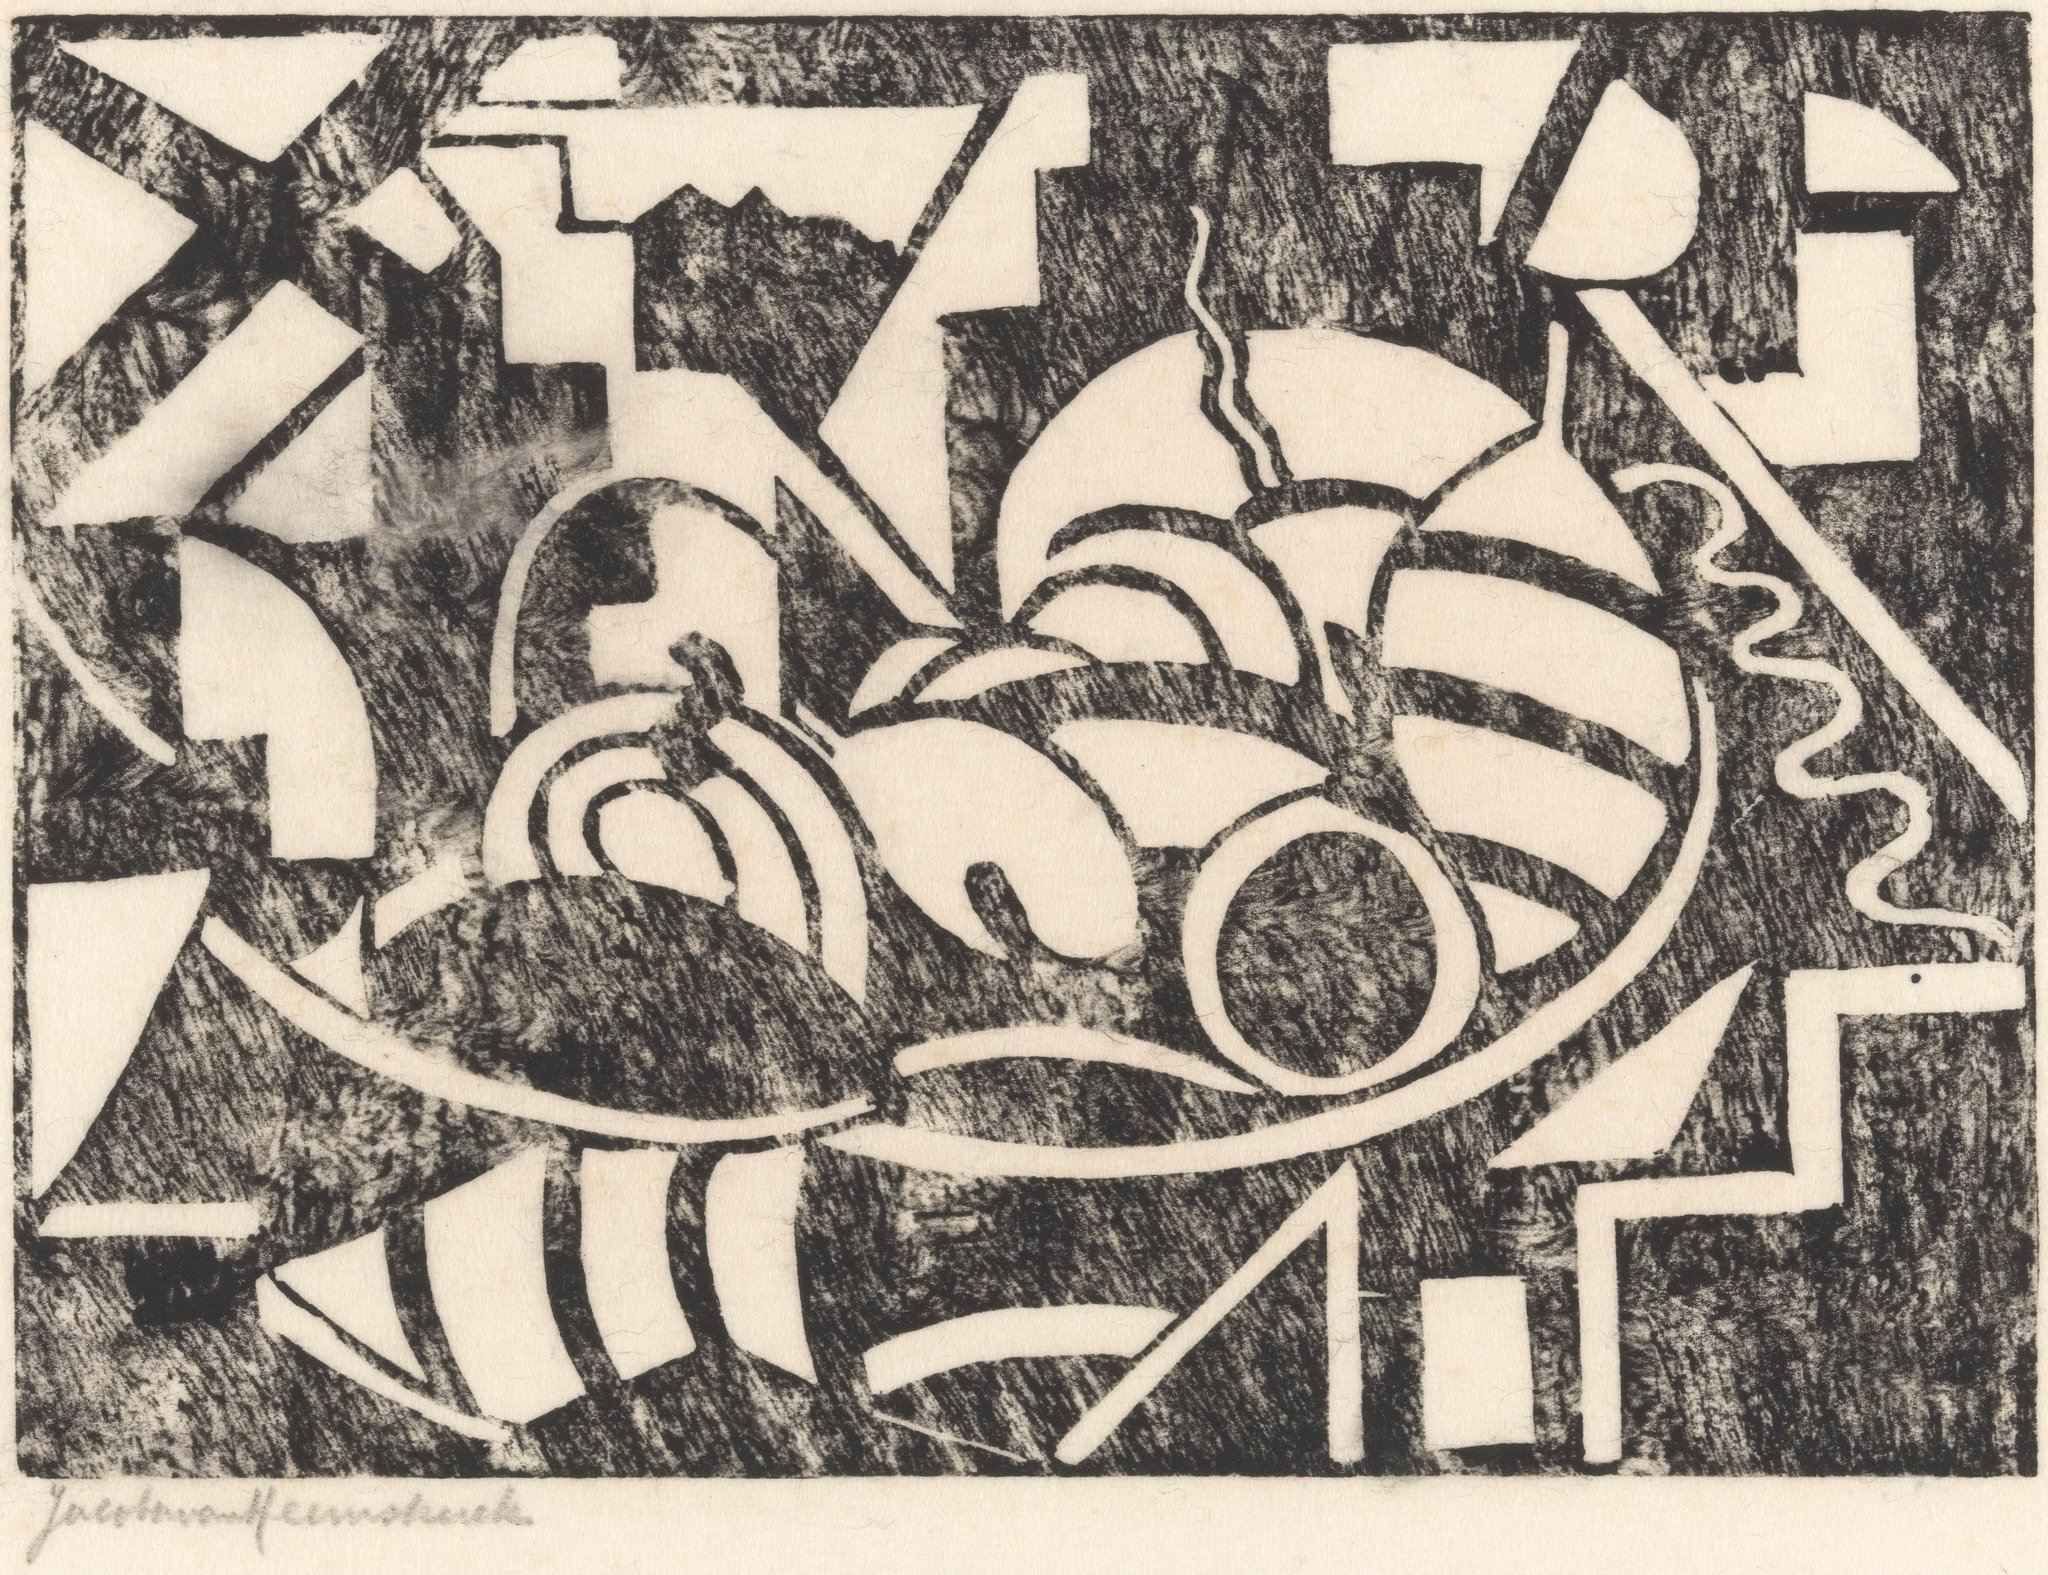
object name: print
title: Compositie (Stilleven)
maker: jacoba van heemskerck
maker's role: draughtsman, painter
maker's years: 1876-1923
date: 1916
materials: paper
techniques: woodcut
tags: fruit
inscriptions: collector's mark: Lugt 2228